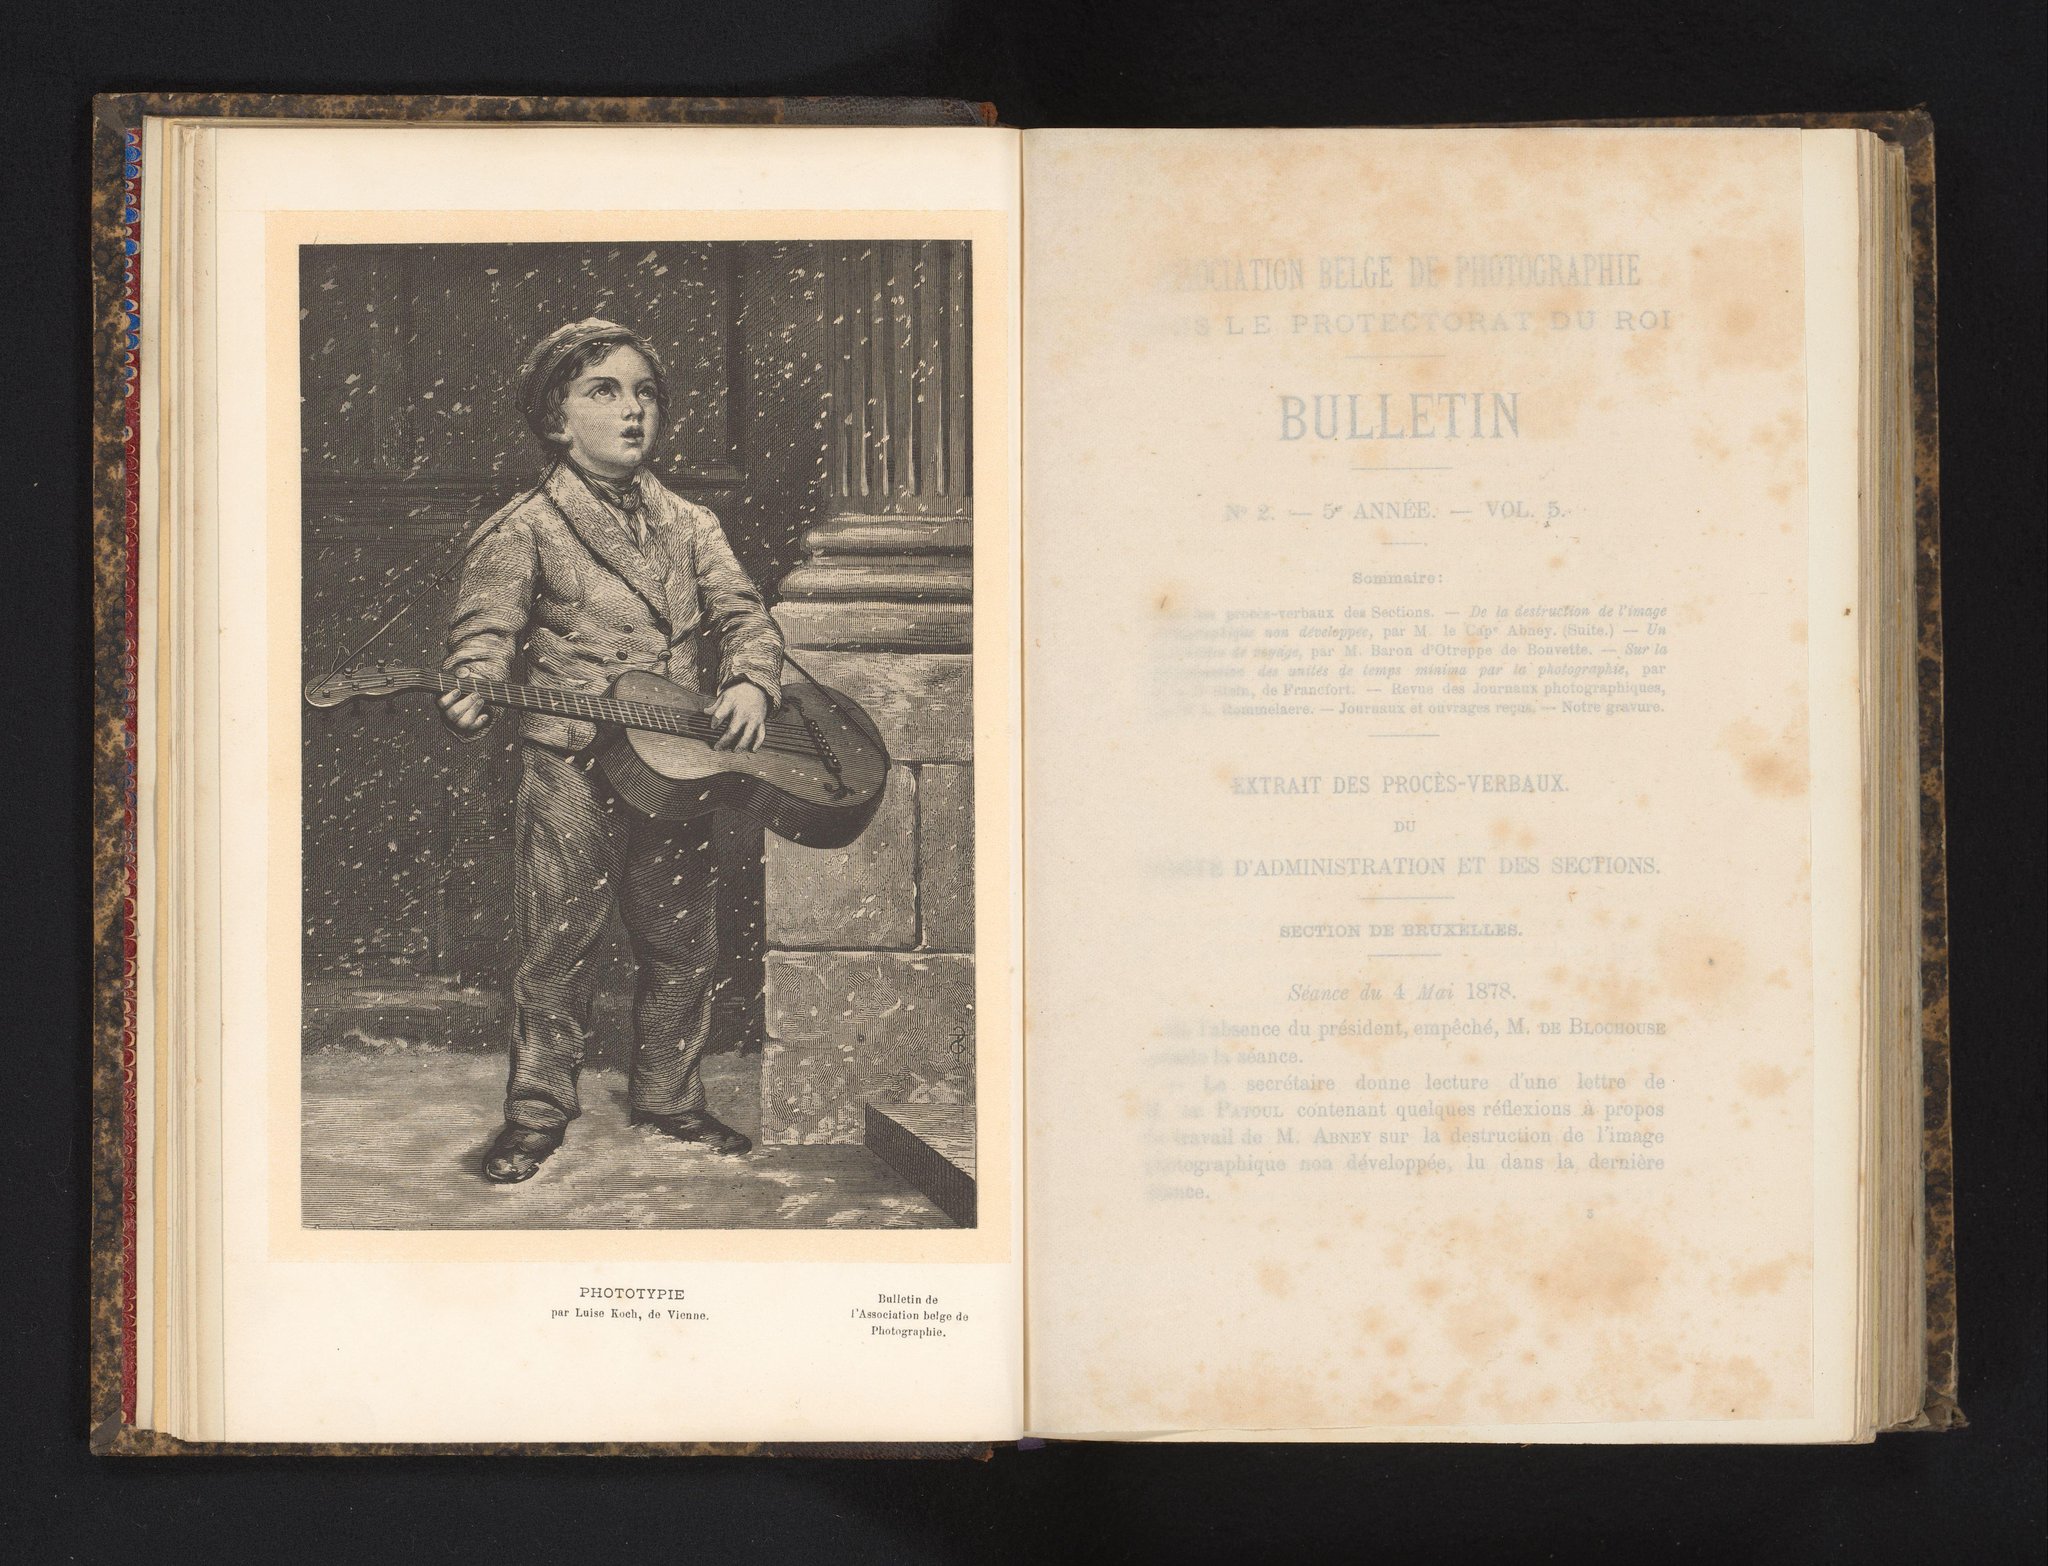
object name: page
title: Reproductie van een ontwerp met de voorstelling van een onbekend kind dat in de sneeuw gitaar speelt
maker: luise koch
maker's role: printer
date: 1873-1878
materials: paper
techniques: photograph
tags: boy (child between toddler and youth), cithern, mandolin, guitar, balalaika, painting, drawing and the graphic arts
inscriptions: inscription: ‘Bulletin de l'Association Belge/ de Photographie’